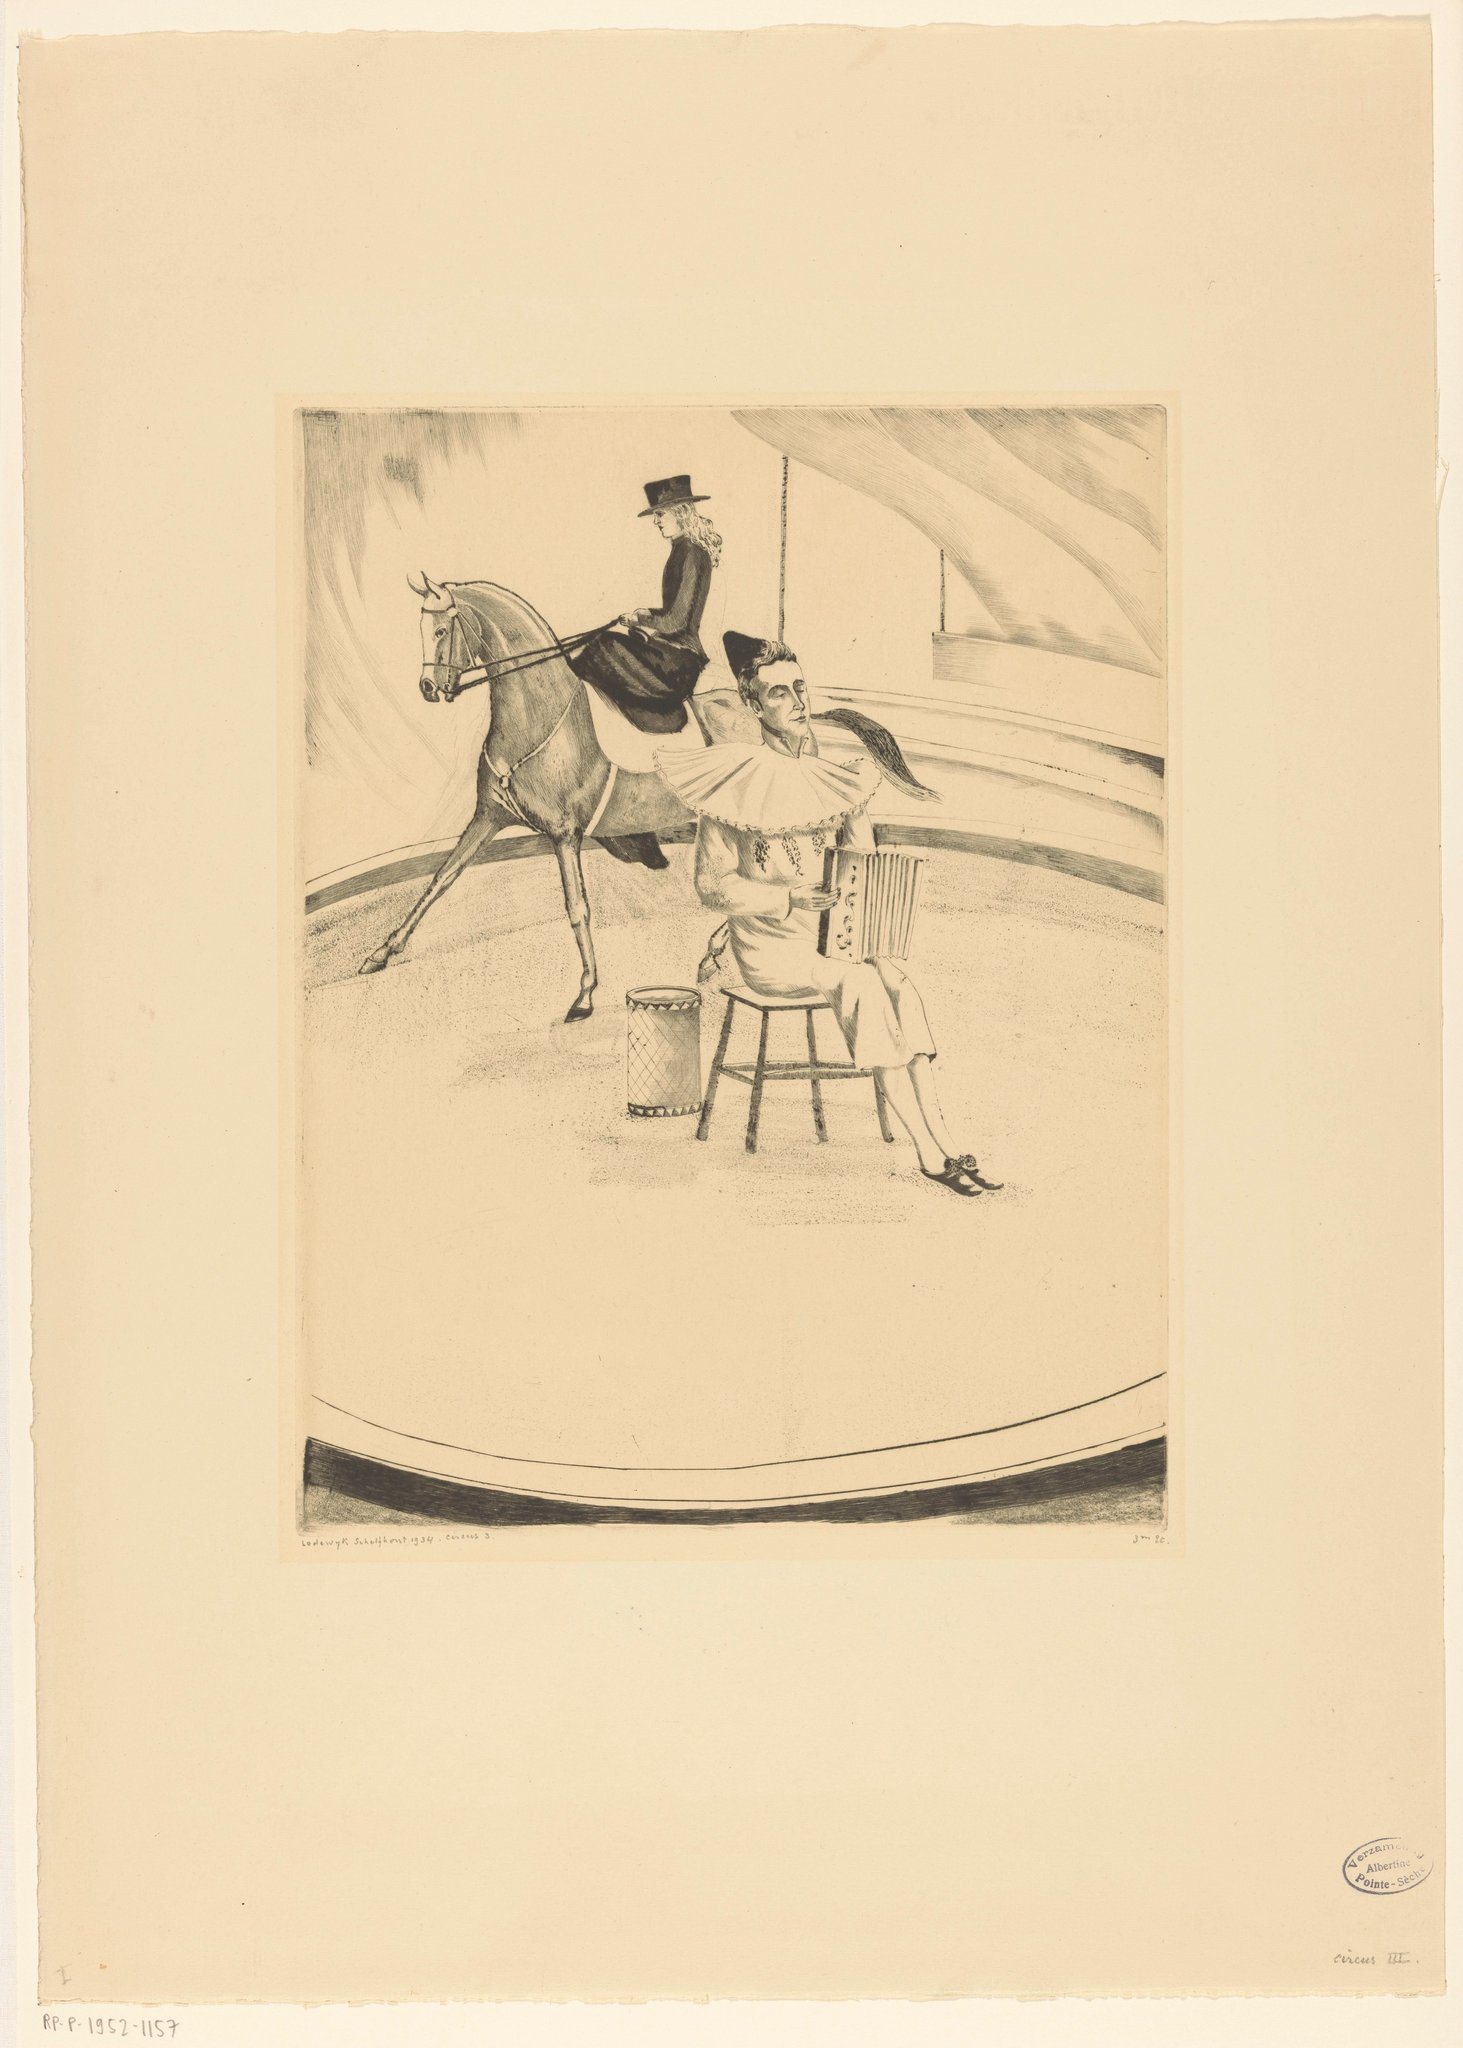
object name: print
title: Clown met accordeon en ruiter op een dressuurpaard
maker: lodewijk schelfhout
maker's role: draughtsman, print maker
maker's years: 1881-1943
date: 1934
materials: paper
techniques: drypoint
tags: accordion, clown, horses (circus performance)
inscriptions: collector's mark: Lugt 2228, collector's mark: Lugt 5i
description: Een clown bespeelt een accordeon terwijl hij op een kruk zit. Op de achtergrond een vrouw die op een paard rijdt.